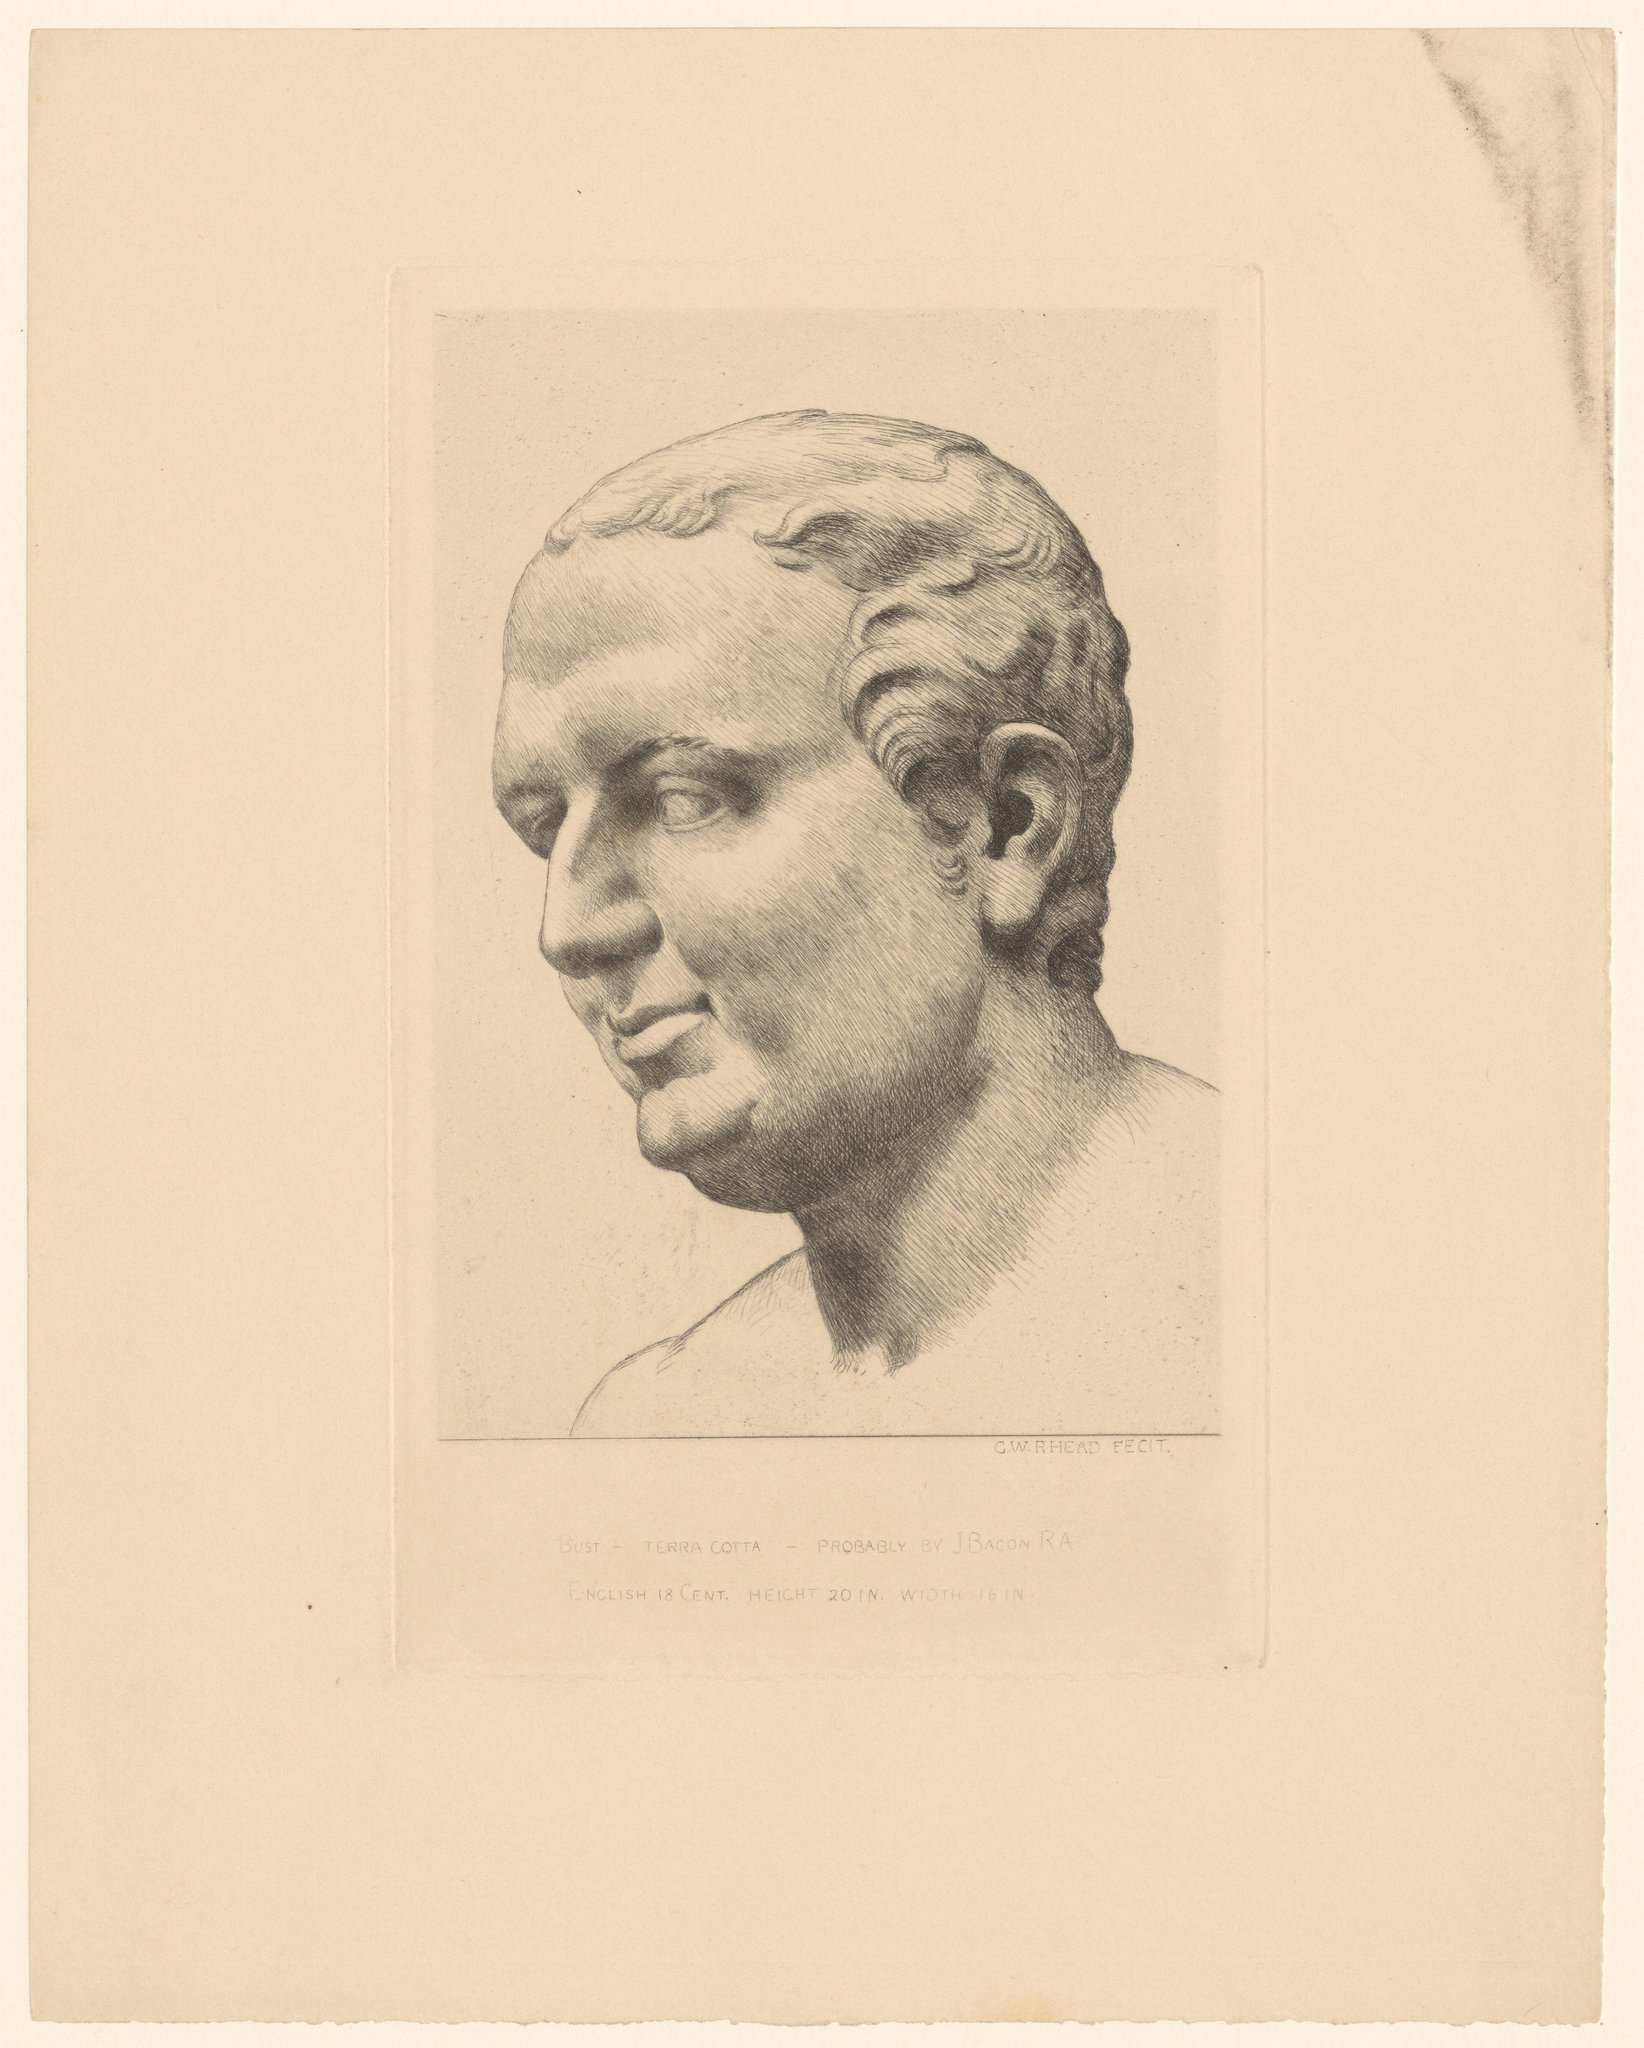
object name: print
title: Portret van een onbekende man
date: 1865-1920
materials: paper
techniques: etching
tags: historical persons, piece of sculpture, reproduction of a piece of sculpture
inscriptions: collector's mark: Lugt 2228